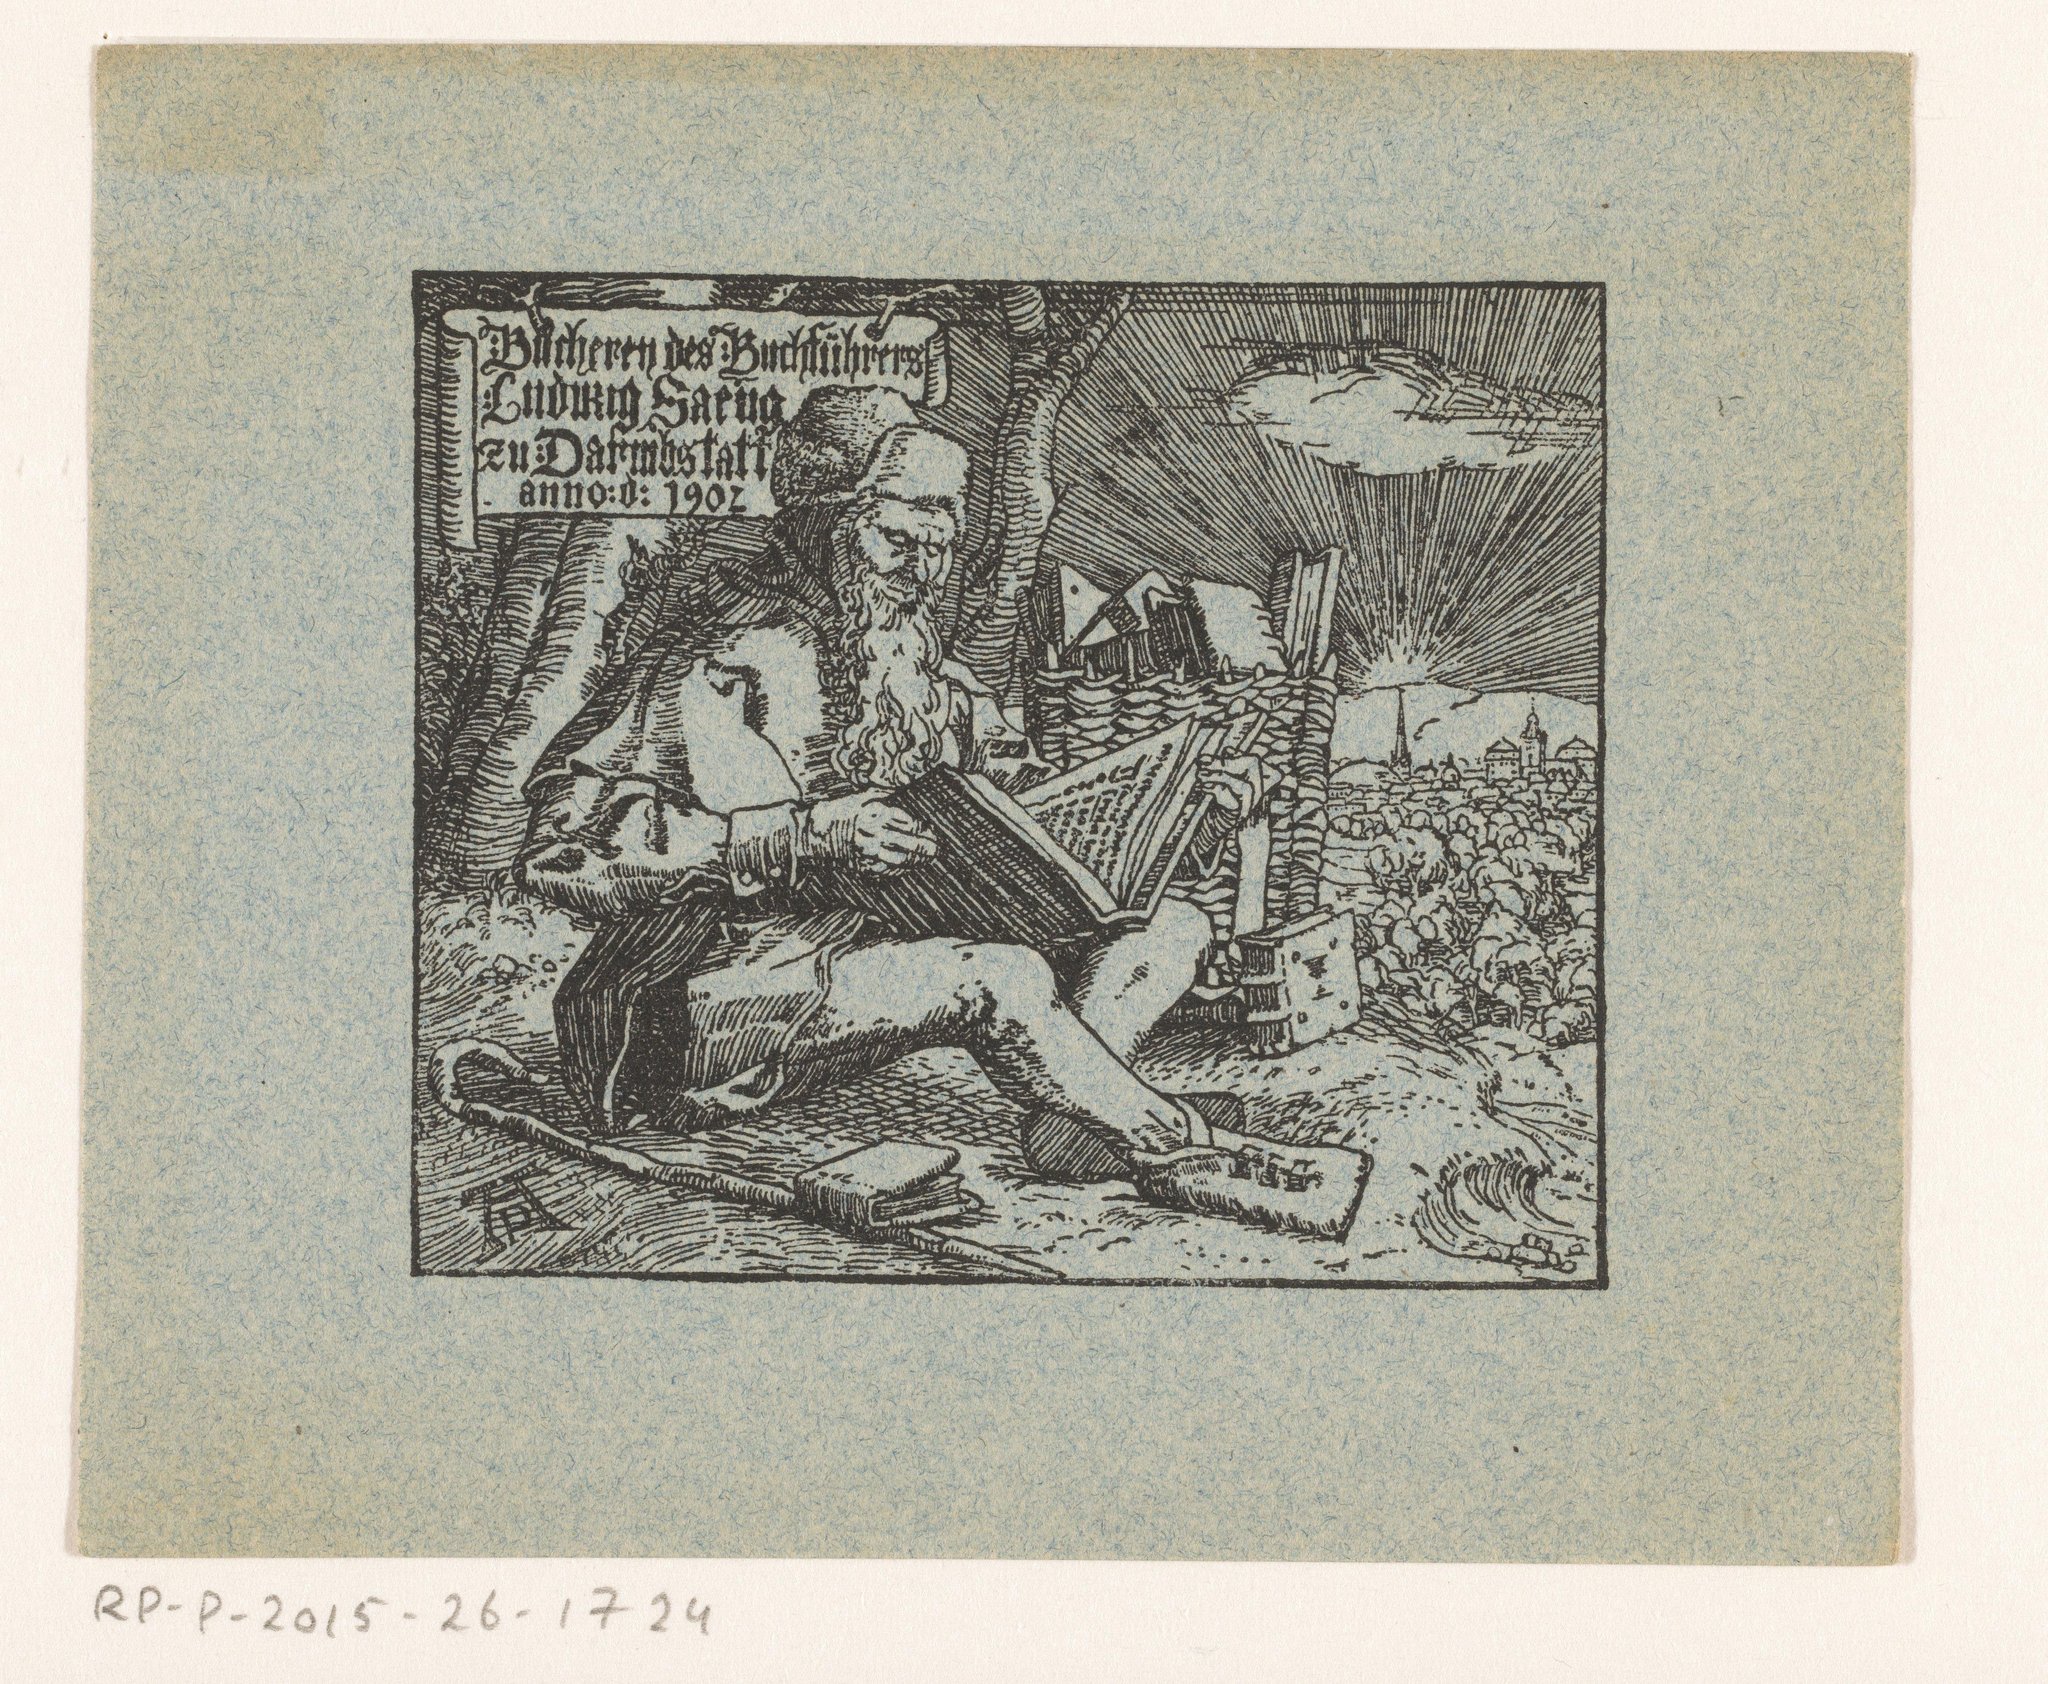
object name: print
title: Ex libris van Ludwig Saeng, boekhandelaar te Darmstadt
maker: Anonymous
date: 1902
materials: paper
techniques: printing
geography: germany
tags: reading, book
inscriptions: collector's mark: Lugt 2228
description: Buiten zit een man in zestiende-eeuwse kleding op de grond te lezen in een boek. Naast hem een wandelstok en twee boeken. In de achtergrond een dorp.